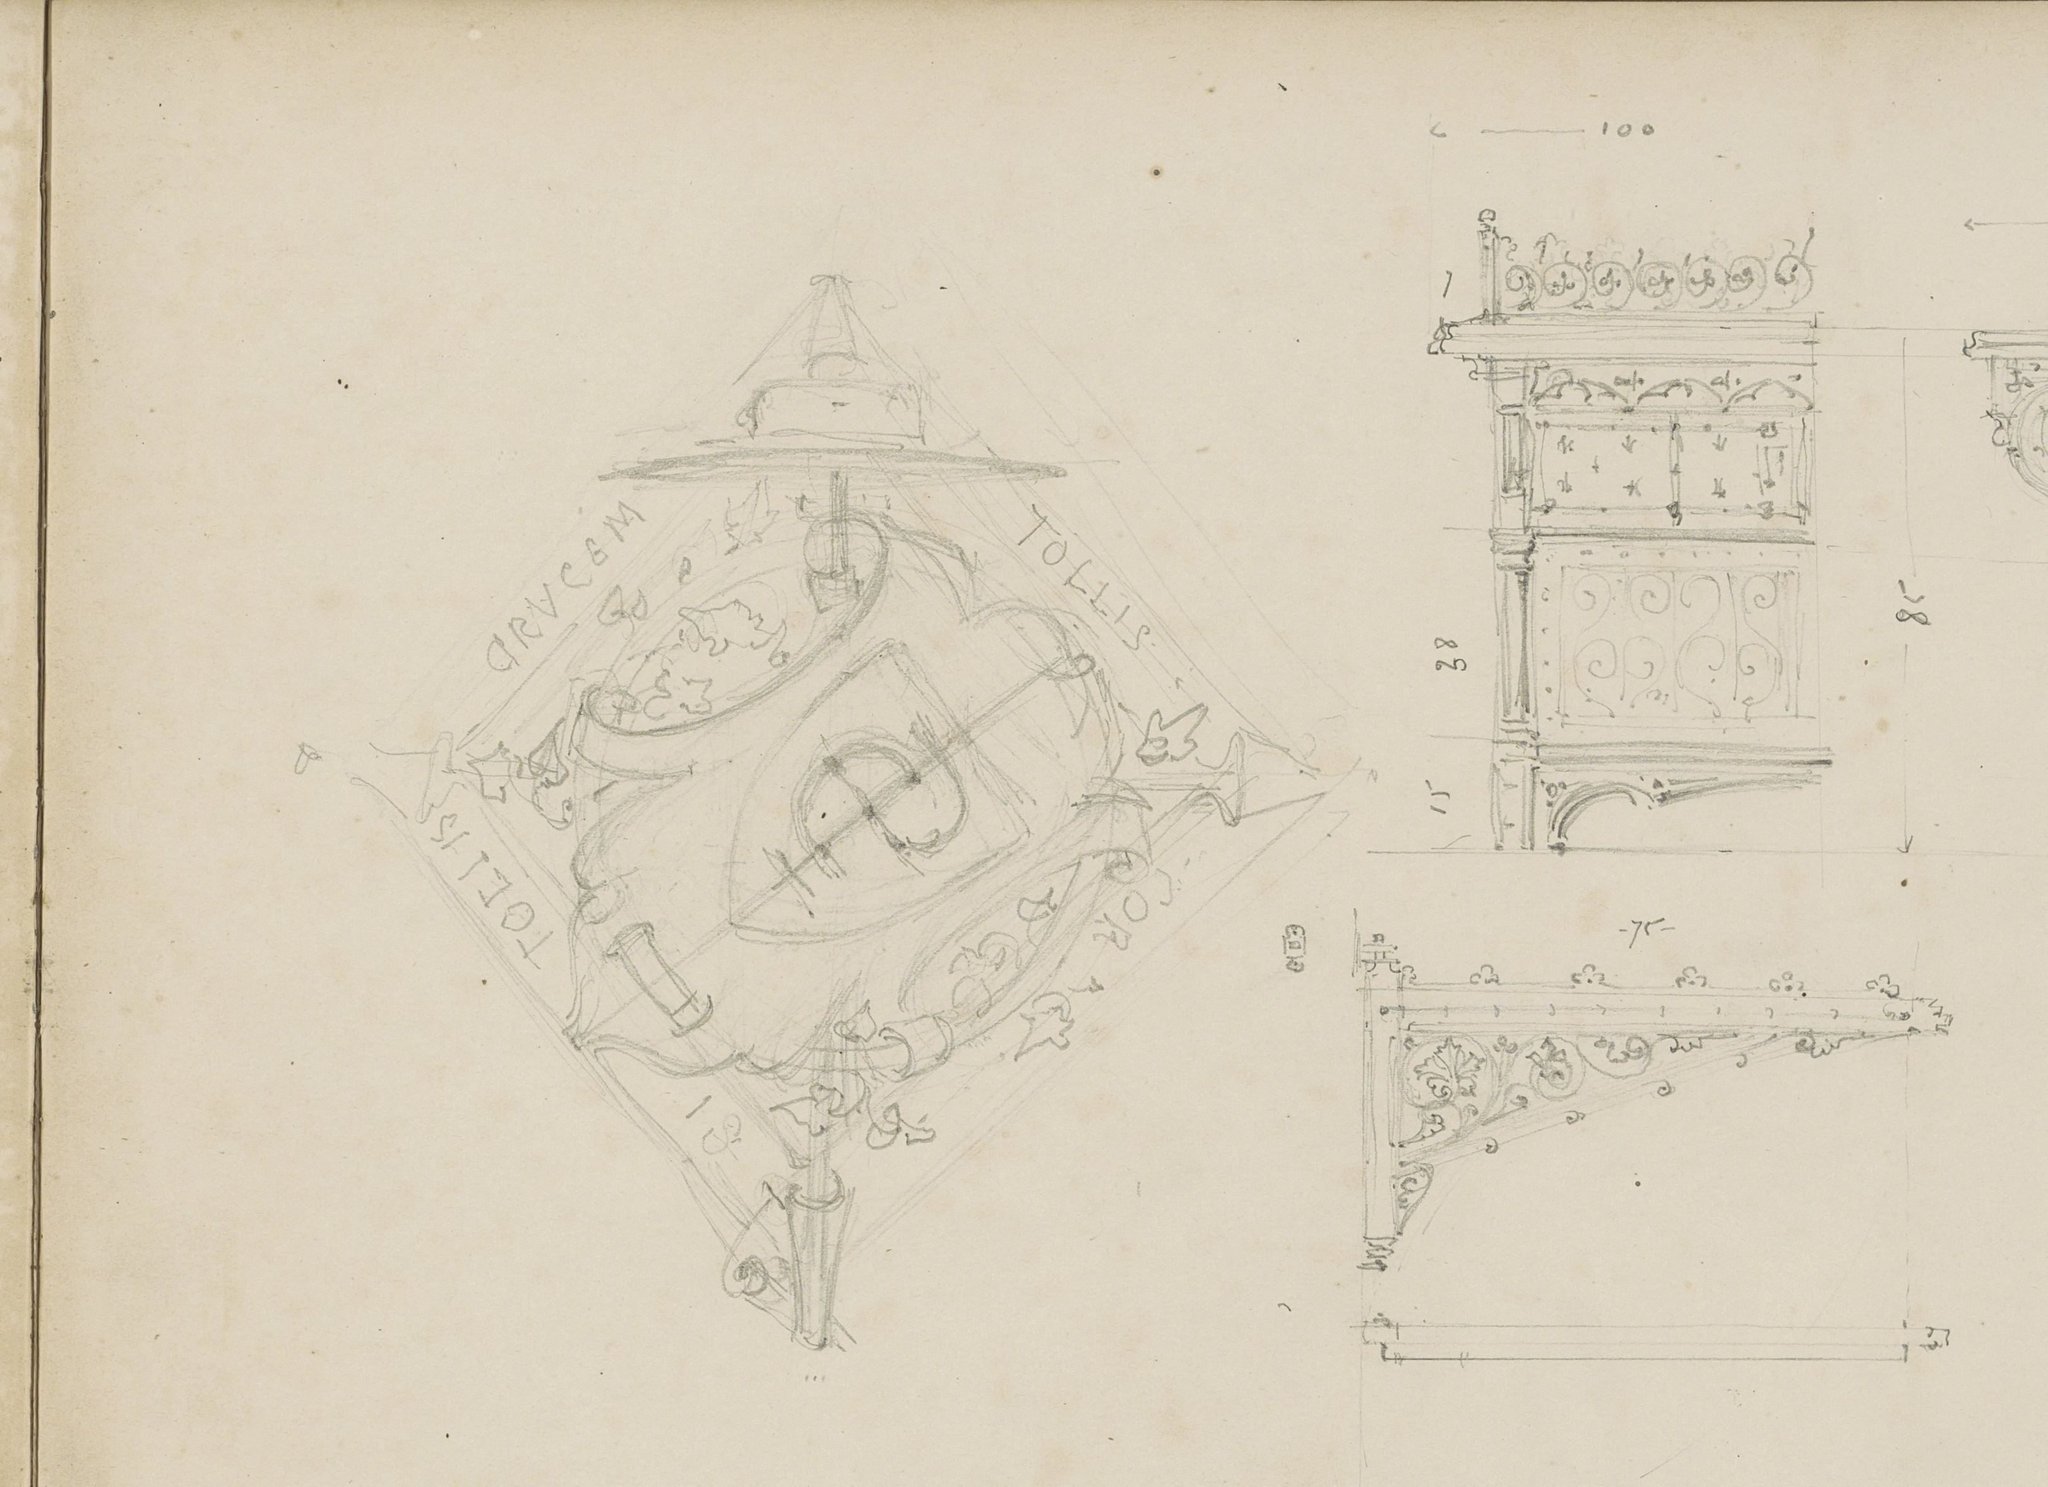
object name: sketchbook leaf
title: Tafels en een wapen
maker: pierre joseph hubert cuypers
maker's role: draughtsman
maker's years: 1827-1921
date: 1857-1859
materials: paper, pencil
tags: coat of arms (as symbol of the state, etc.), table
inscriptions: annotation: ‘[...]’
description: Blad 66 recto uit een schetsboek met 77 bladen.